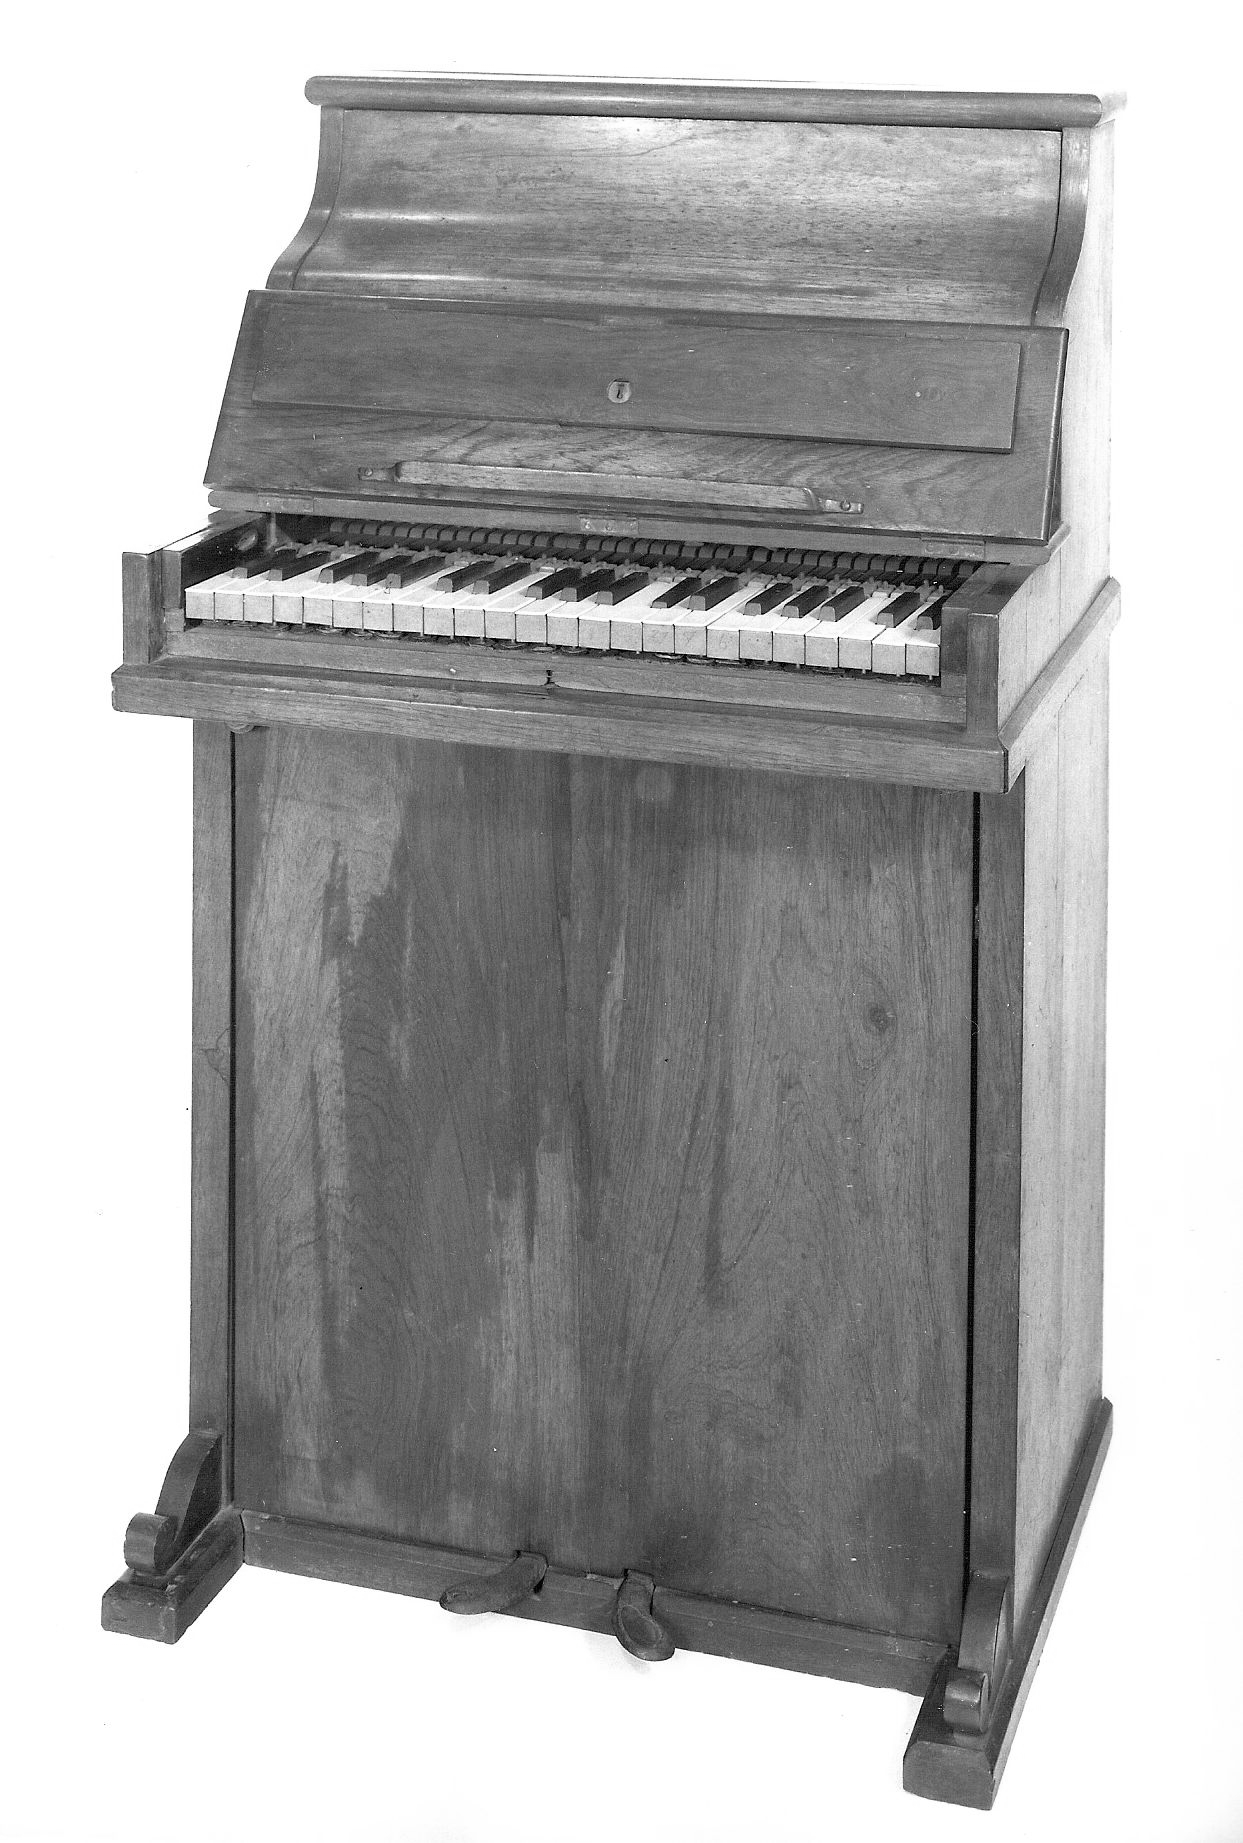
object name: upright piano and reed organ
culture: american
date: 1834-1866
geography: united states